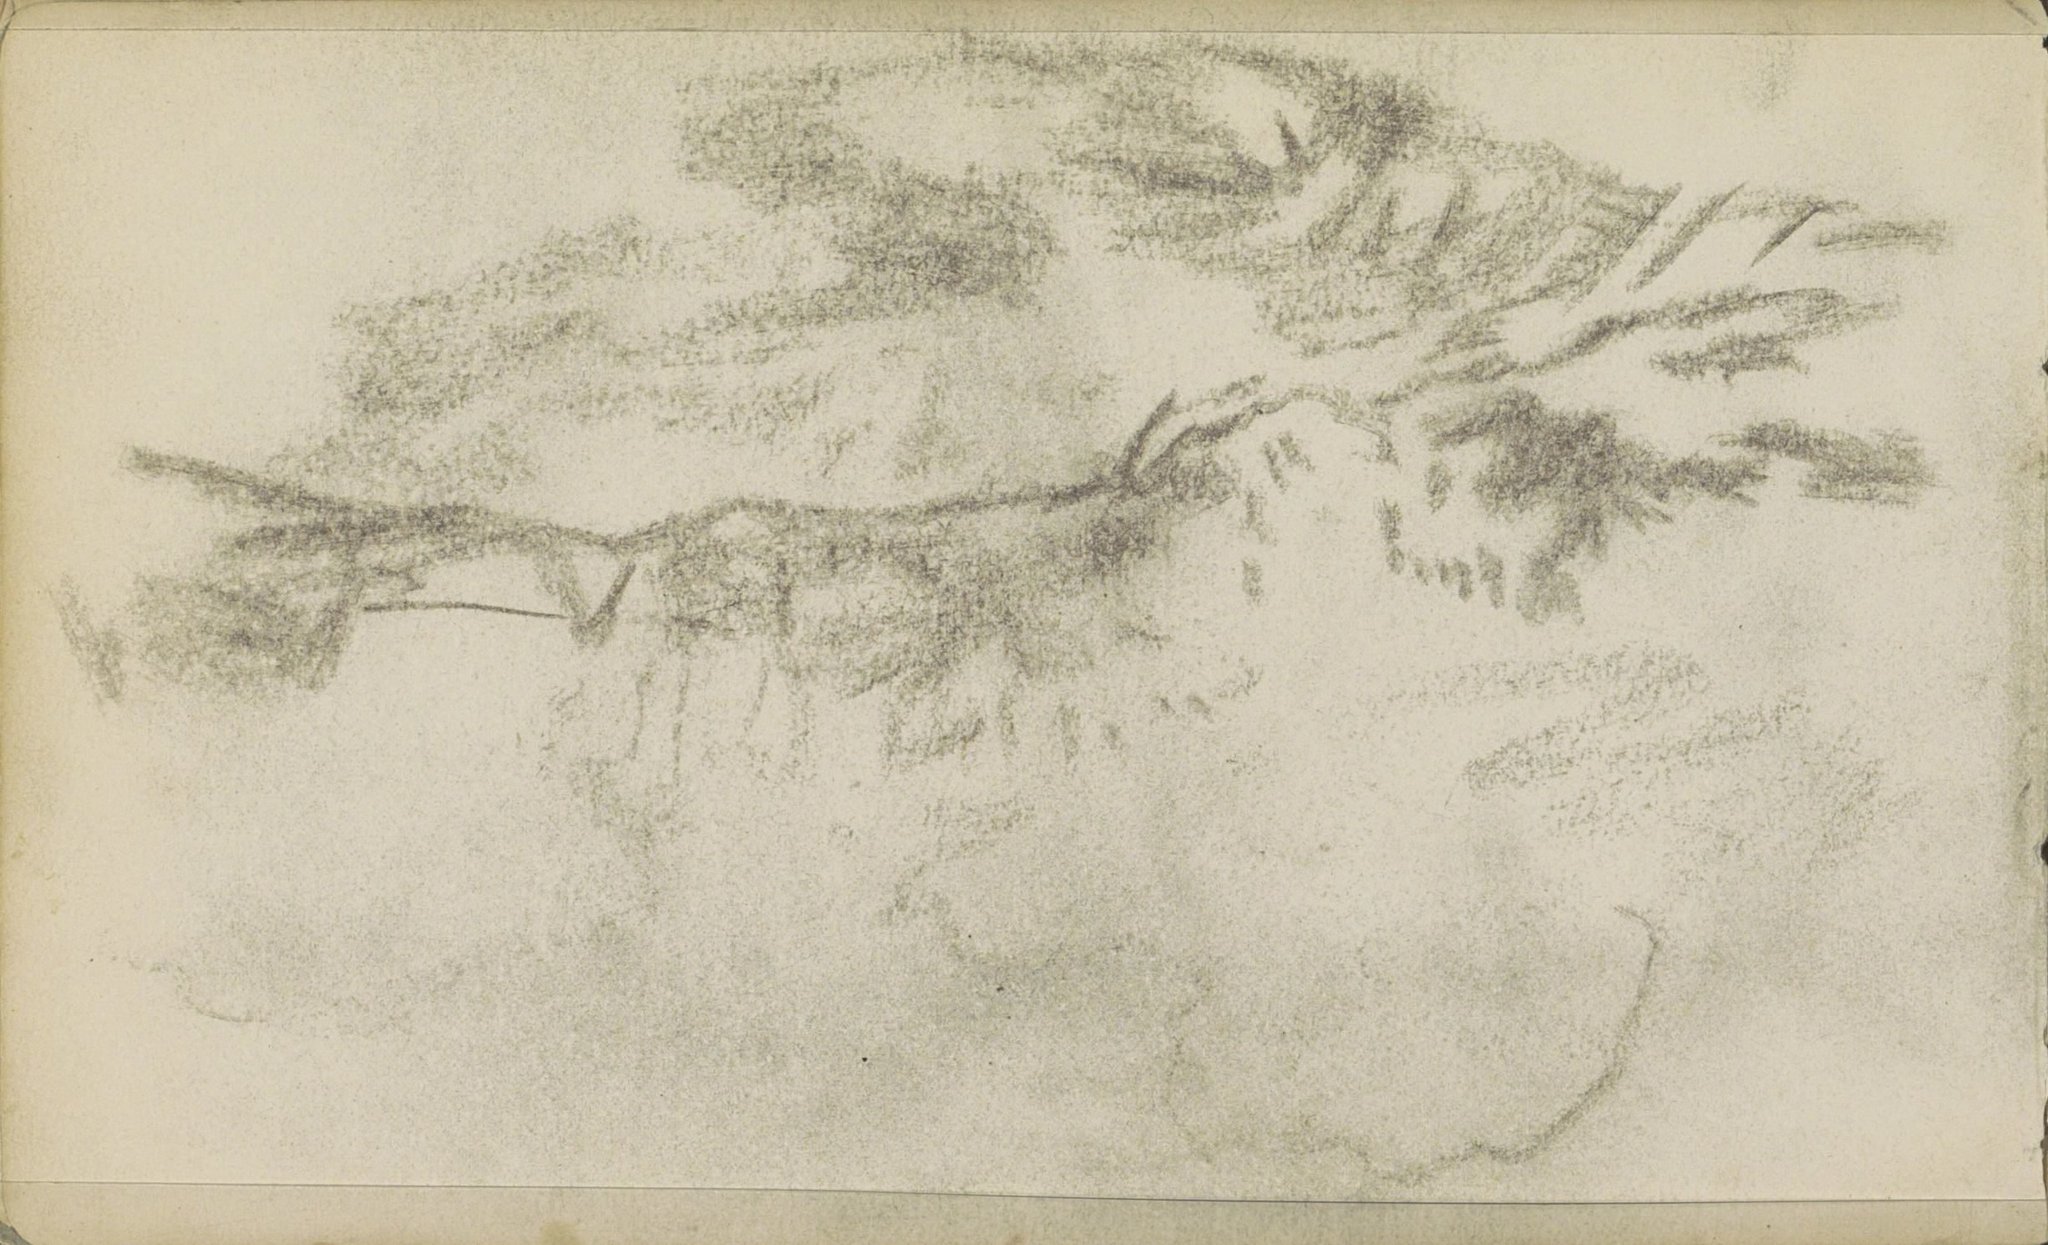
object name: sketchbook leaf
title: Landschap met struiken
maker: jozef israëls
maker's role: draughtsman, painter, print maker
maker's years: 1824-1911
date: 1834-1911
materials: chalk, paper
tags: landscapes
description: Blad 8 verso uit een schetsboek met 42 bladen.